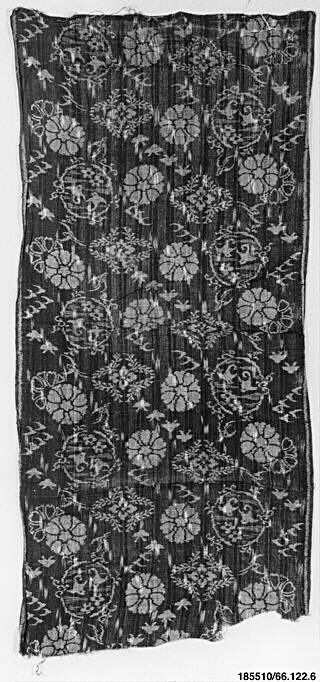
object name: piece of cloth for kimono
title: Piece of Cloth for Kimono with Pattern of Cherry Blossoms, Floral Medallions, Birds, and Vertical Splashes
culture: japanese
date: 1801-1900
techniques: patterning, weave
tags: flowers